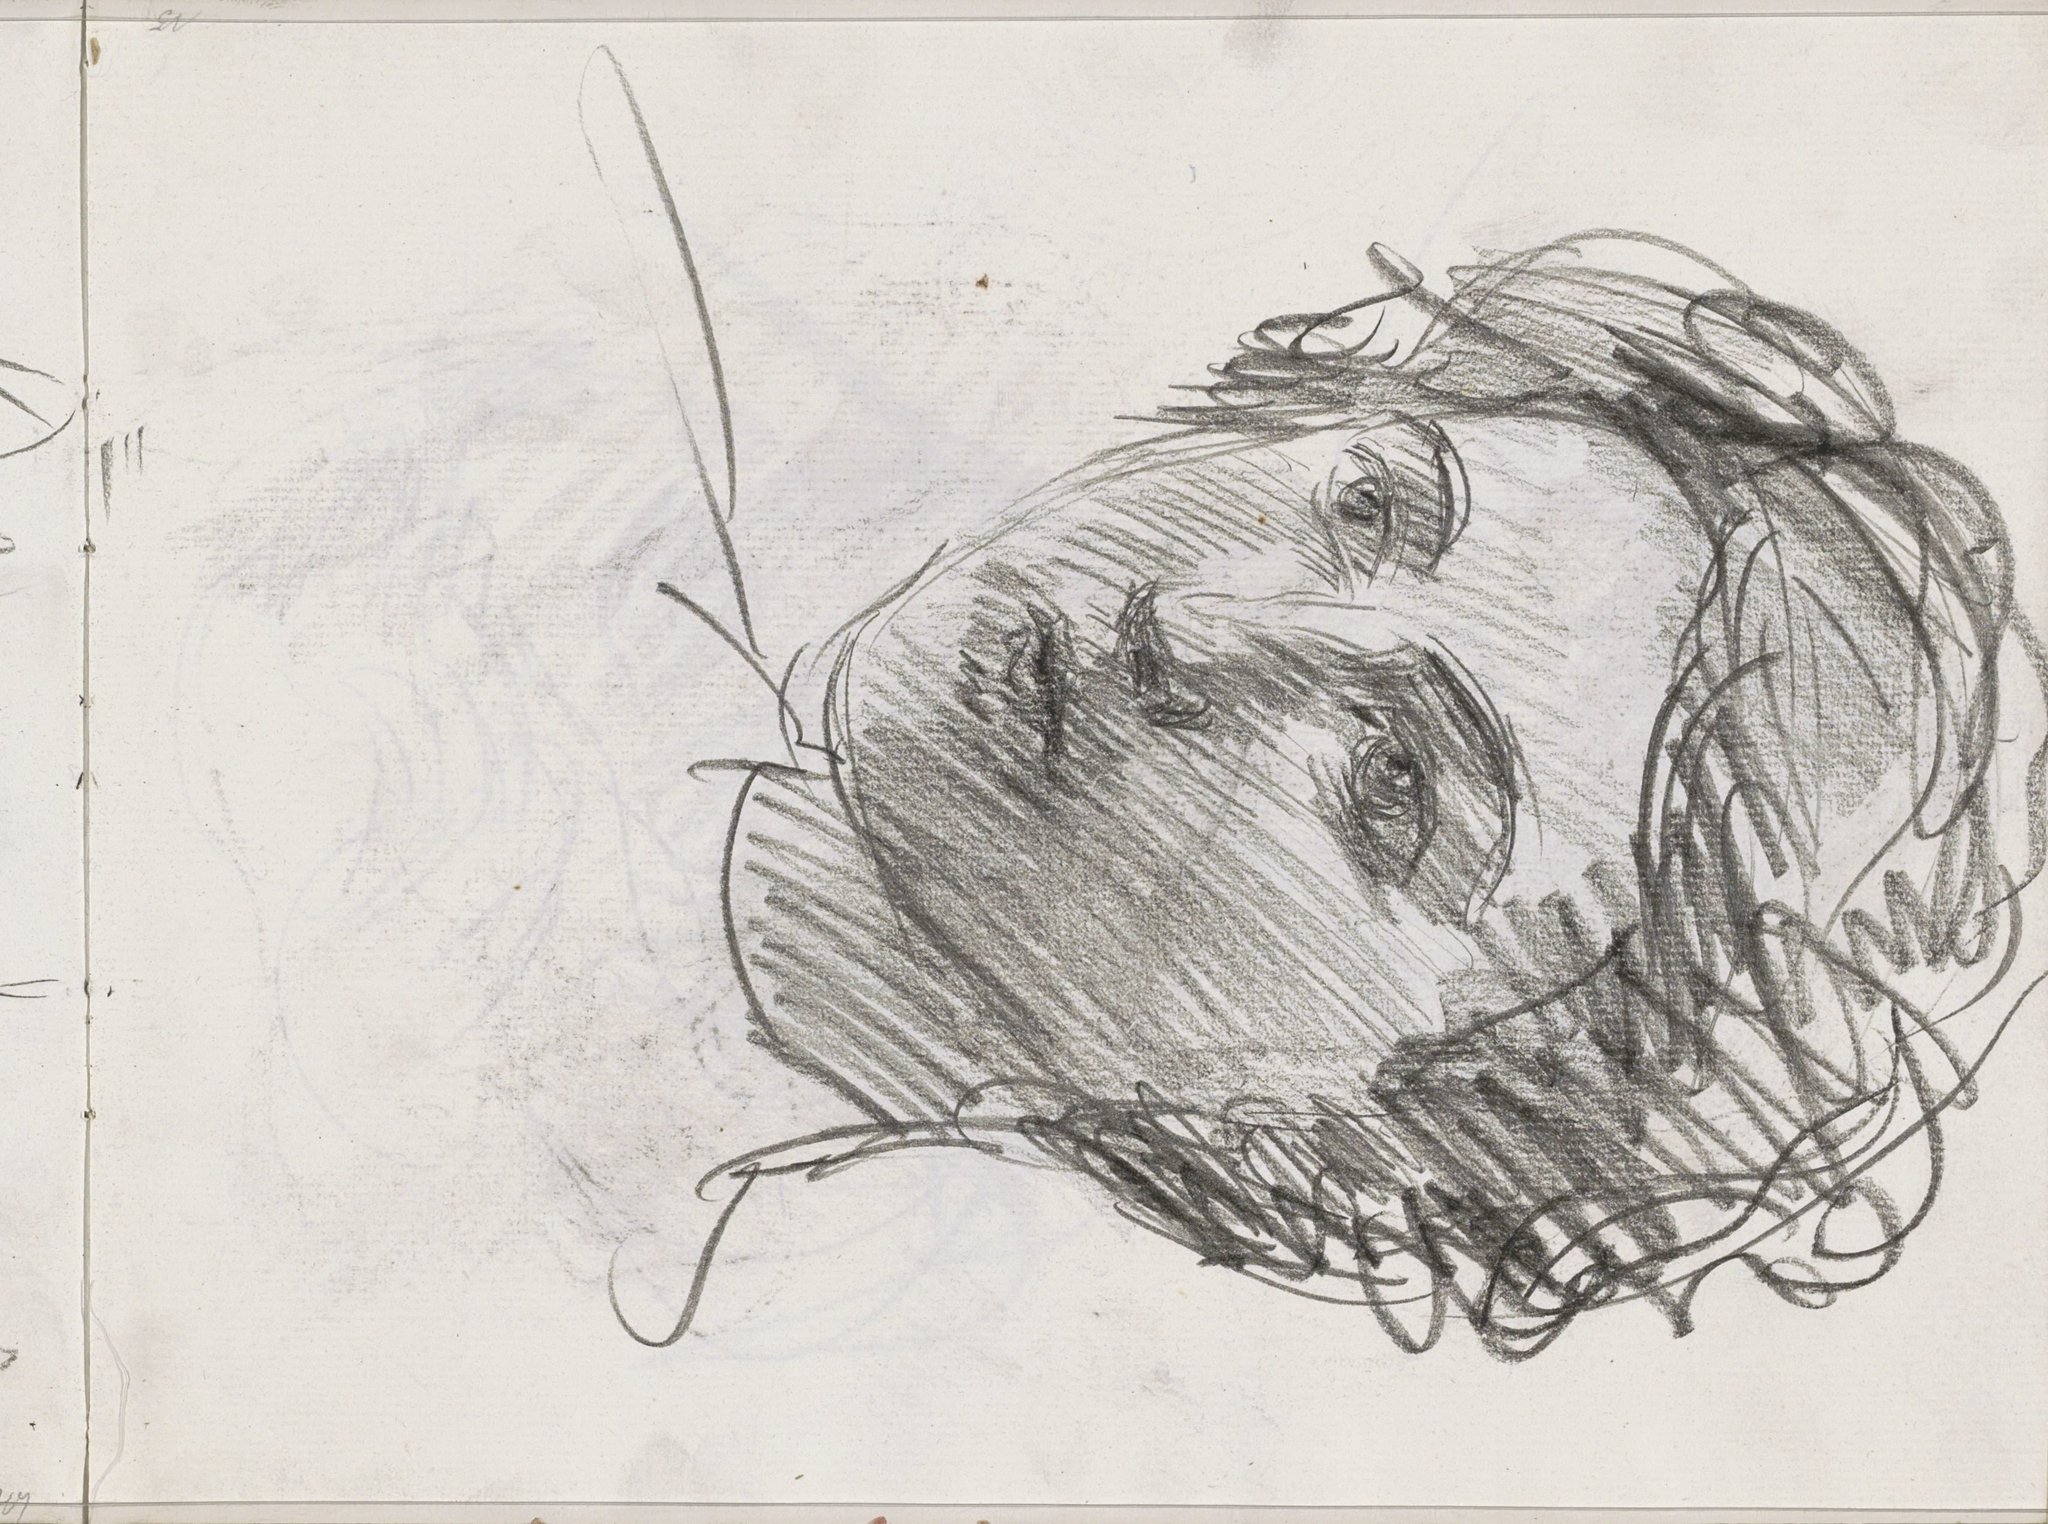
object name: sketchbook leaf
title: Vrouwenhoofd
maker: isaac israels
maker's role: draughtsman, painter, print maker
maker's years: 1865-1934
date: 1875-1934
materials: chalk, paper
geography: the hague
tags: head (human) - aa - female human figure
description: Blad 17 recto uit schetsboek XXII met 30 bladen.